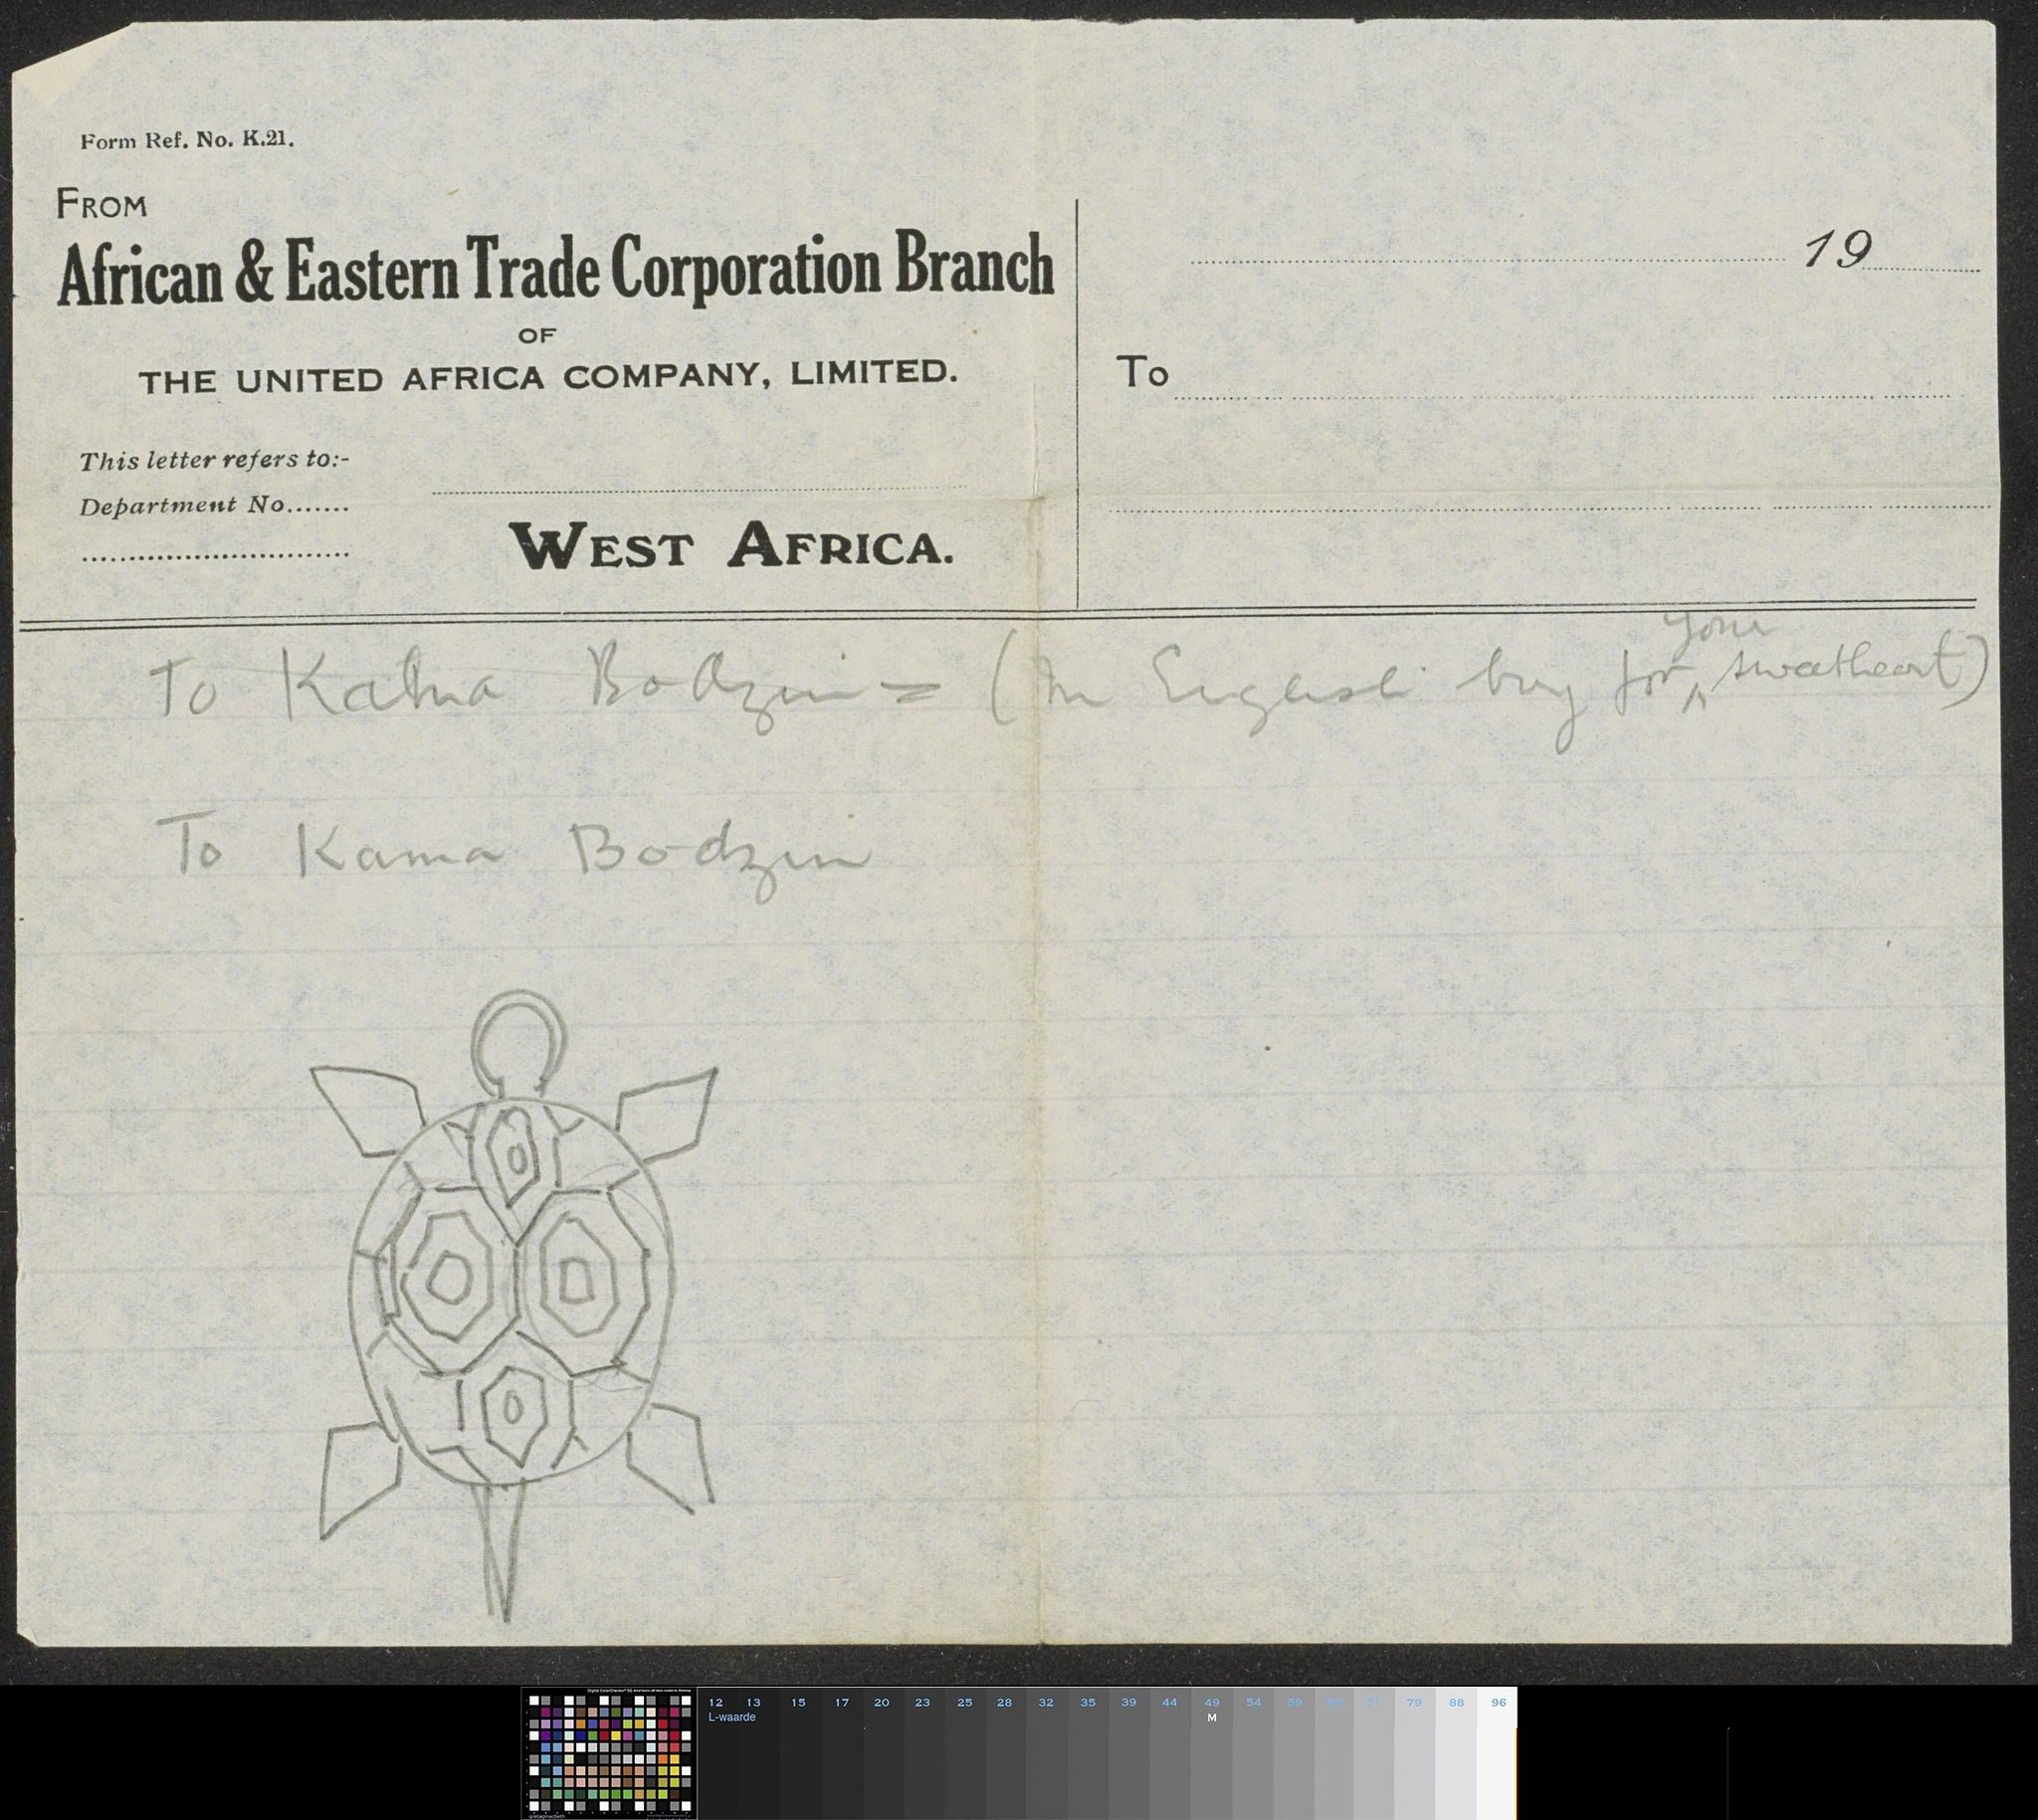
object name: sketchbook leaf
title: Schildpad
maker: reijer stolk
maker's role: draughtsman, print maker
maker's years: 1896-1945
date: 1916-1945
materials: pencil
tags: tortoises, turtles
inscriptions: annotation: ‘To Kama Bodzin = (In English buy for you sweetheart)/ To Kama Bodzin’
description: Tekening en annotatie op briefpapier van de African & Eastern Trade Corporation Branch of The United Africa Company, Limited.